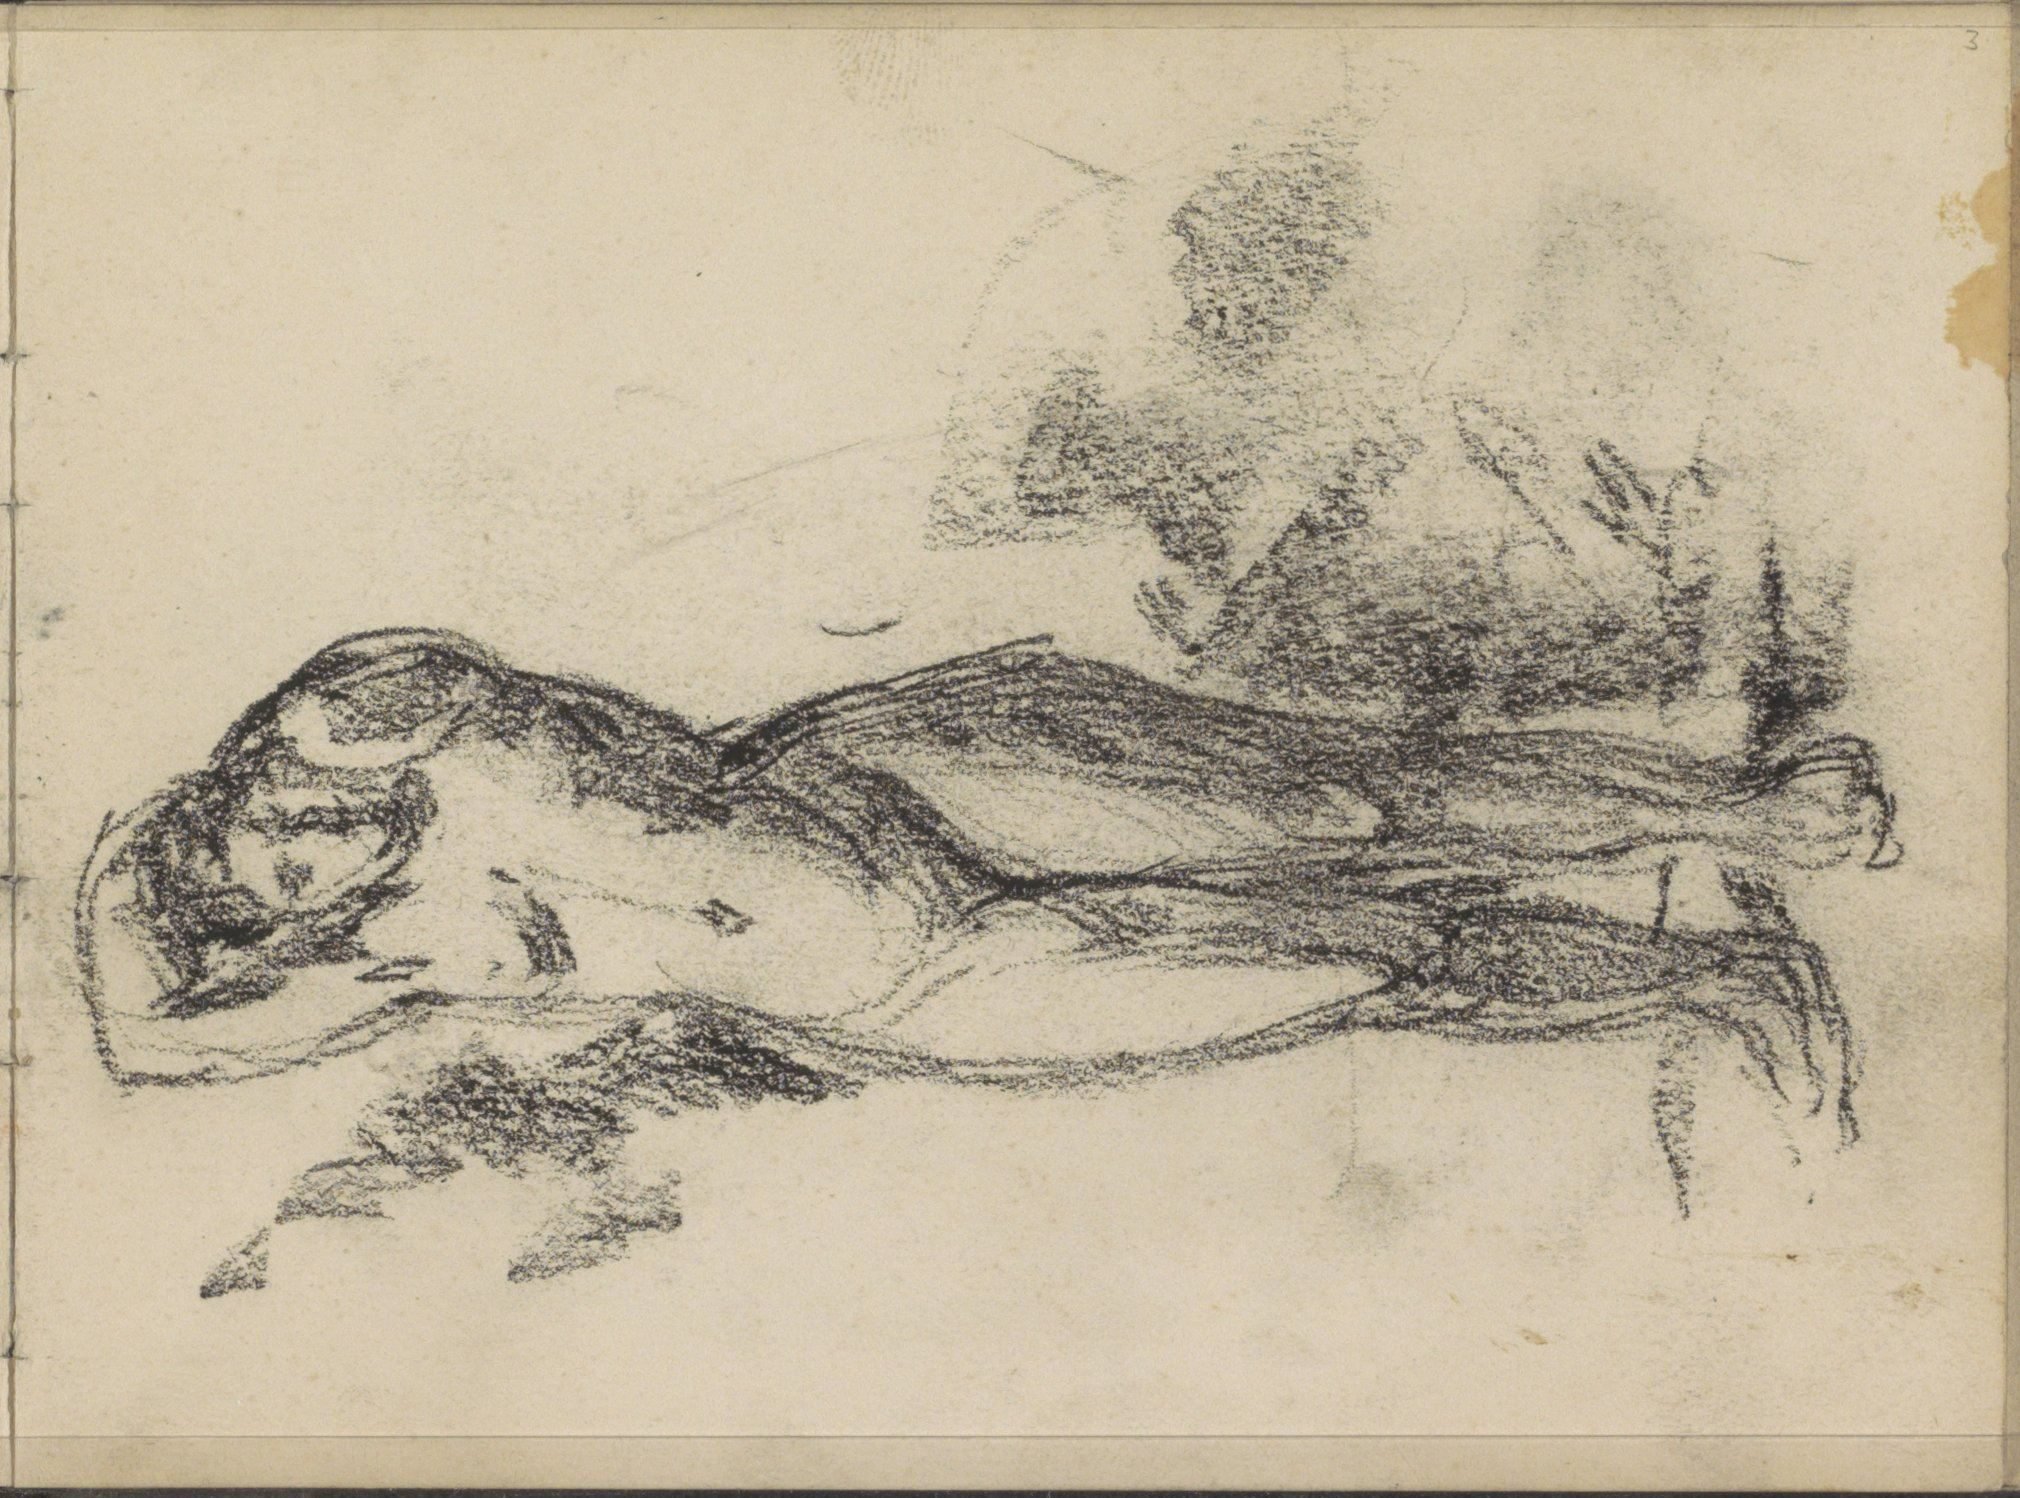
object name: sketchbook leaf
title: Vrouwelijk naakt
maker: marius bauer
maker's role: draughtsman, print maker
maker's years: 1867-1932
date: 1879-1884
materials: chalk, paper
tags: standing figure, adult woman, the (nude) human figure; 'corpo humano' (ripa) - aa - female human figure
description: De vrouw is van voren en ten voeten uit getekend met de armen opgeheven. Pagina 3 uit een schetsboek met 28 bladen.